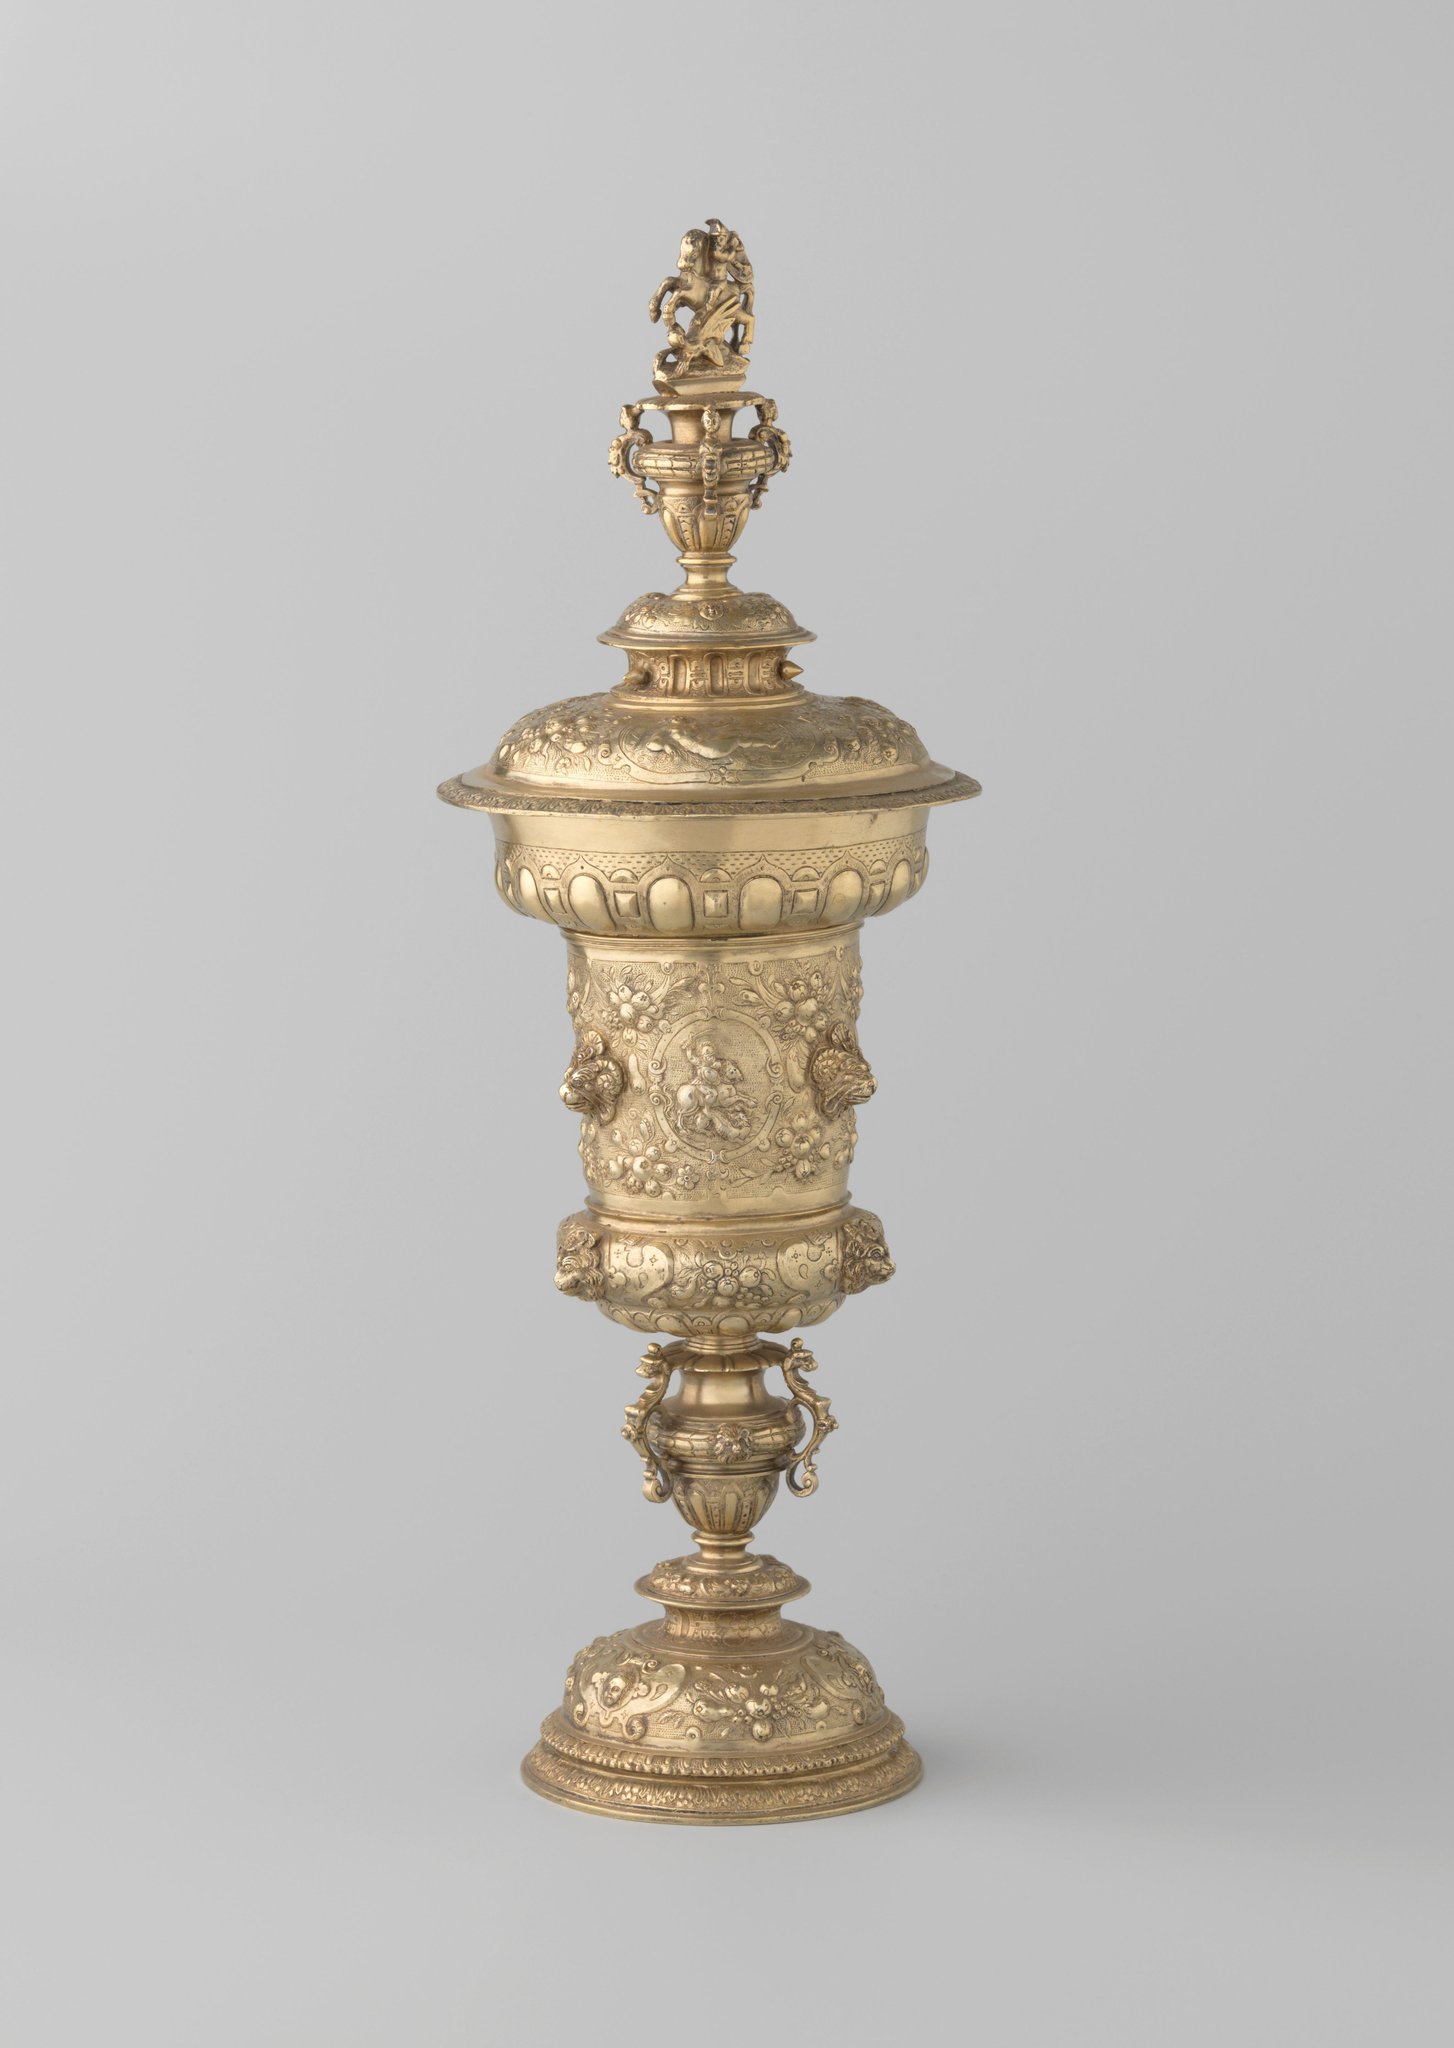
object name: cup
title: Galvanoplastische reproductie van de beker van het St. Jorisgilde van Middelburg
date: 1881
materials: copper, silver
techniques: galvanoplasty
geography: london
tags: middelburg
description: Galvanoplastische reproductie van de beker van het St. Jorisgilde van Middelburg. De cuppa, op een balustervormige stam, met drie wapenschilden en leeuwenkoppen; op het deksel vier medaillons met vrucht- en bloemornamenten en een figuur van St. Joris.